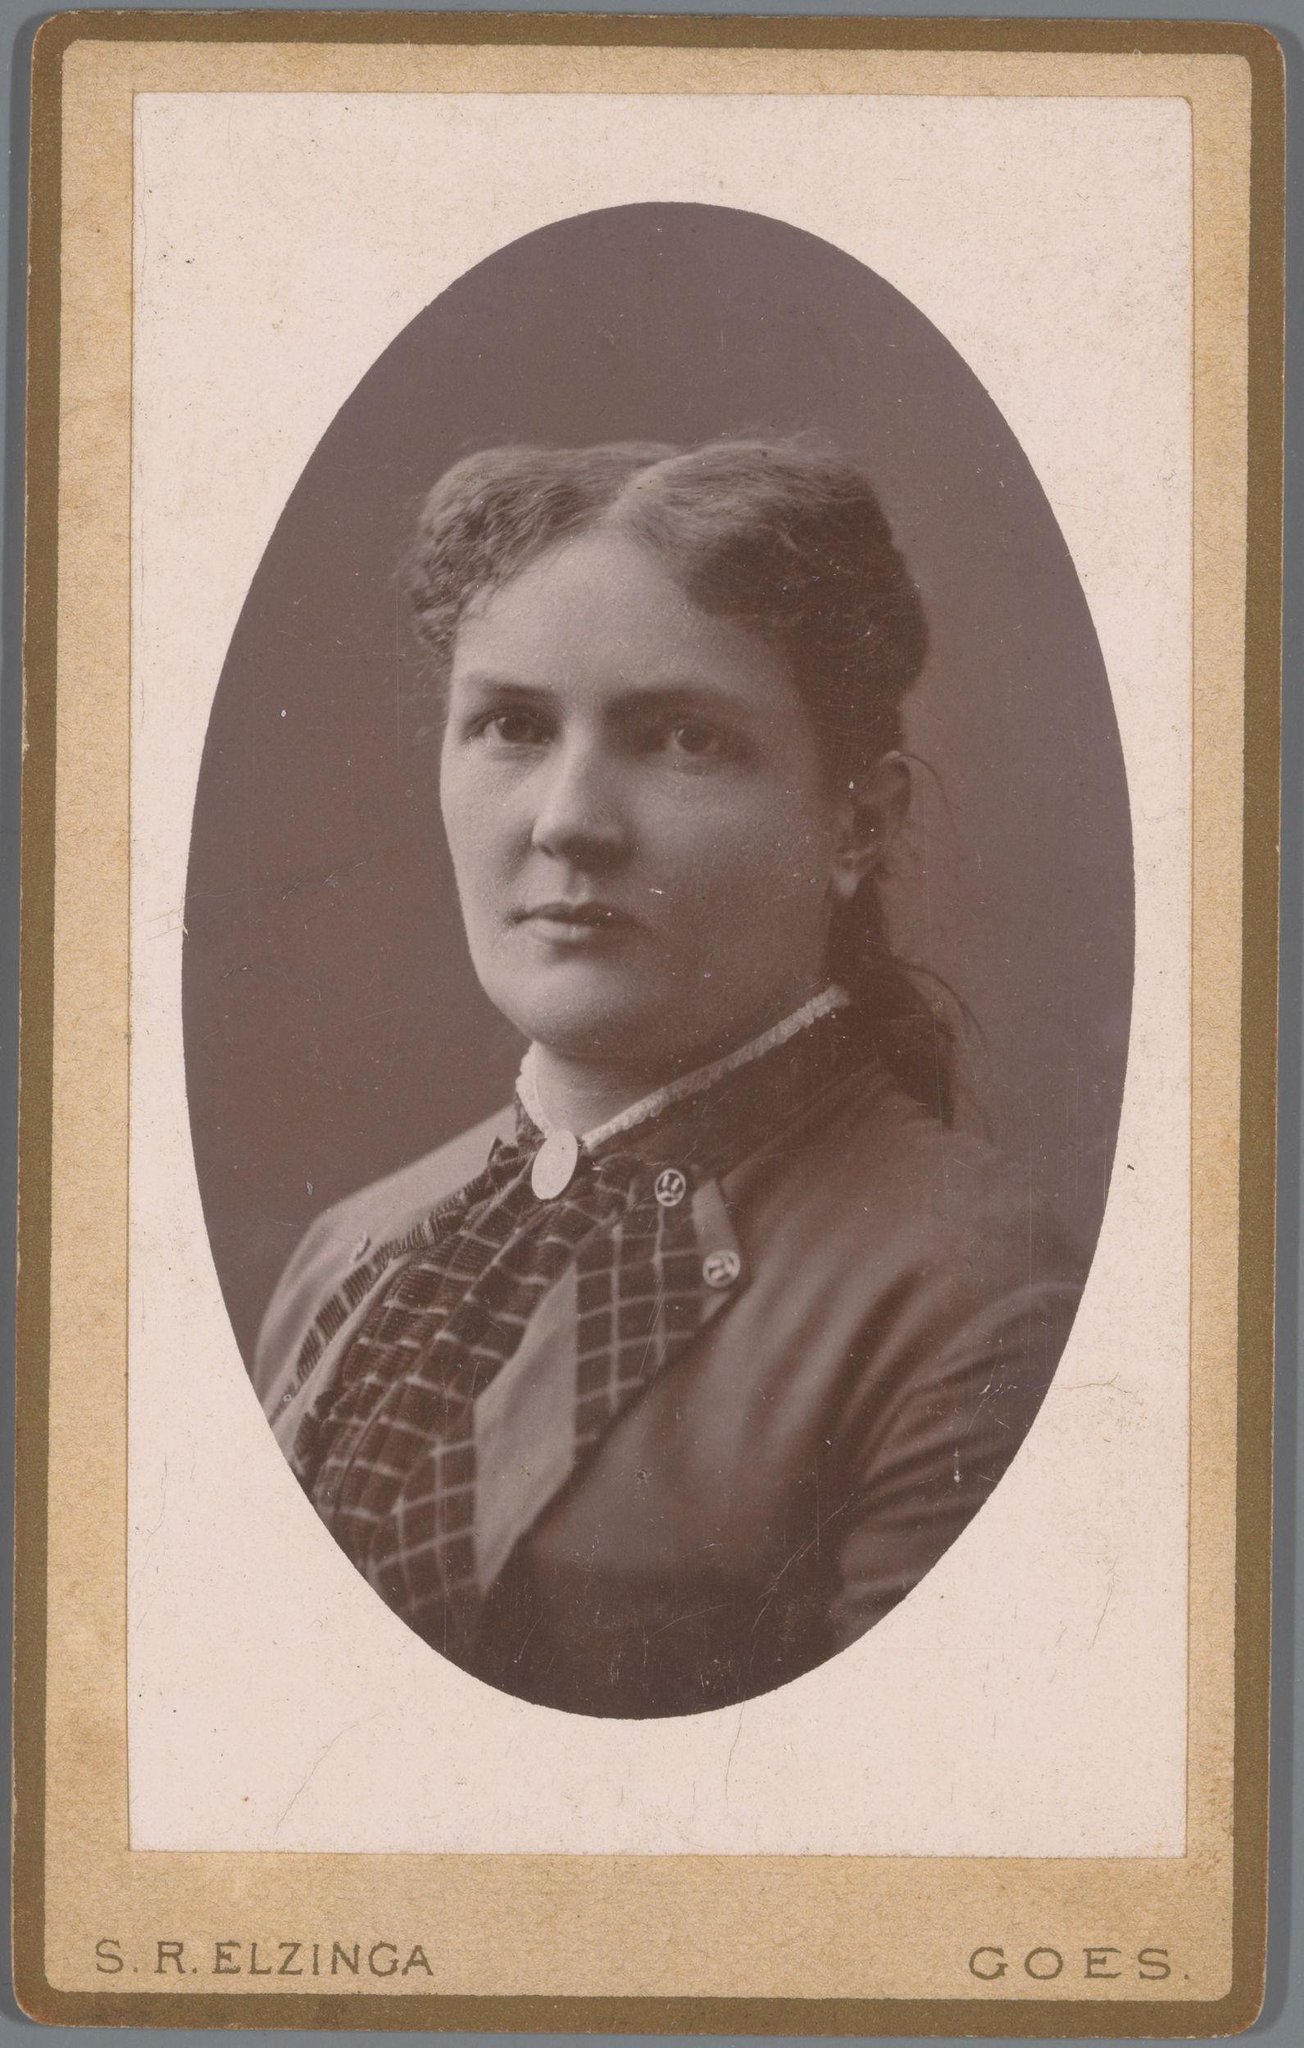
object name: photograph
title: Portret van een onbekende vrouw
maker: sytze reinder elzinga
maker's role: fotograaf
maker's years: 1858-1912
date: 1882-1903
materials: paper, cardboard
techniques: collodion silver print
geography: goes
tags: adult woman, anonymous historical person portrayed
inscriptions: address: ‘Laurens Pieter van de Spiegelstraat./ Goes.’, inscription: ‘Nieuwste Inrichting voor vergrootingen/ naar album of kleinere portretjes.’